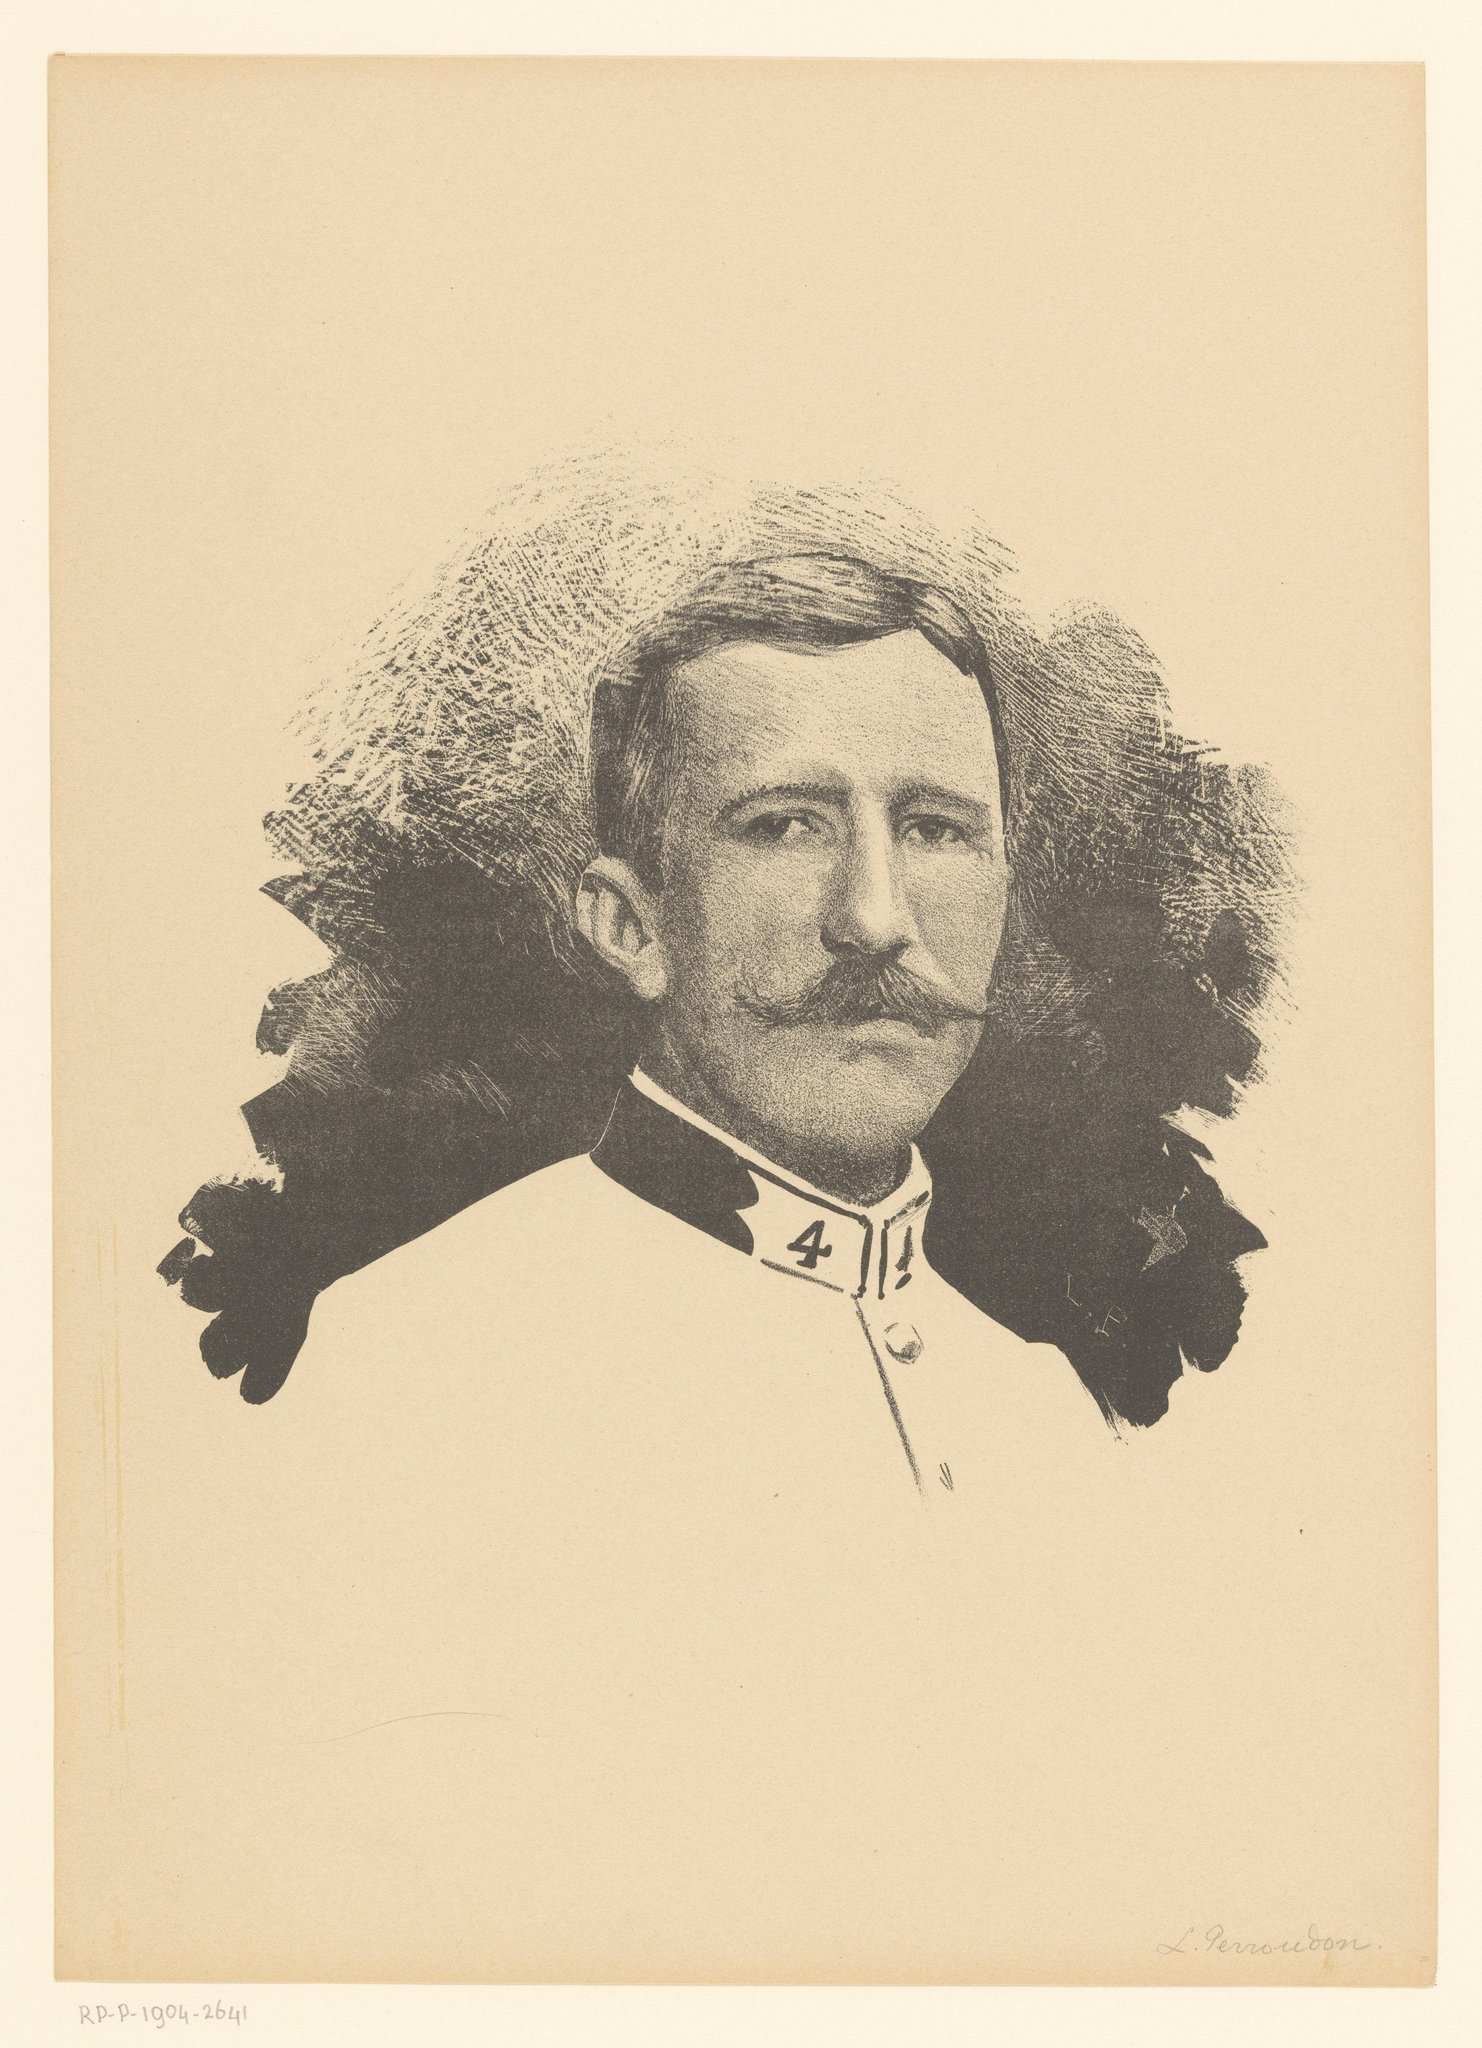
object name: print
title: Portret van Georges Picquart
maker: lucien perroudon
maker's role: print maker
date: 1899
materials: paper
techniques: lithograph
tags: georges picquart, minister ~ government, historical persons, officer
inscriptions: collector's mark: Lugt 2228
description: Prent uit: Hommage des artistes a Picquart. Album de 12 lithographies. Parijs: Société libre d'édition des gens de lettres, 1899. Onder supervisie van Félix Thureau en Paul Brenet uitgegeven als protest tegen de gevangenneming van kolonel Georges Picquart na zijn ontdekkingen met betrekking tot de Dreyfusaffaire. Met voorwoord van Octave Mirabeau en uitleg over de namenlijst door Henri Rainaldy.